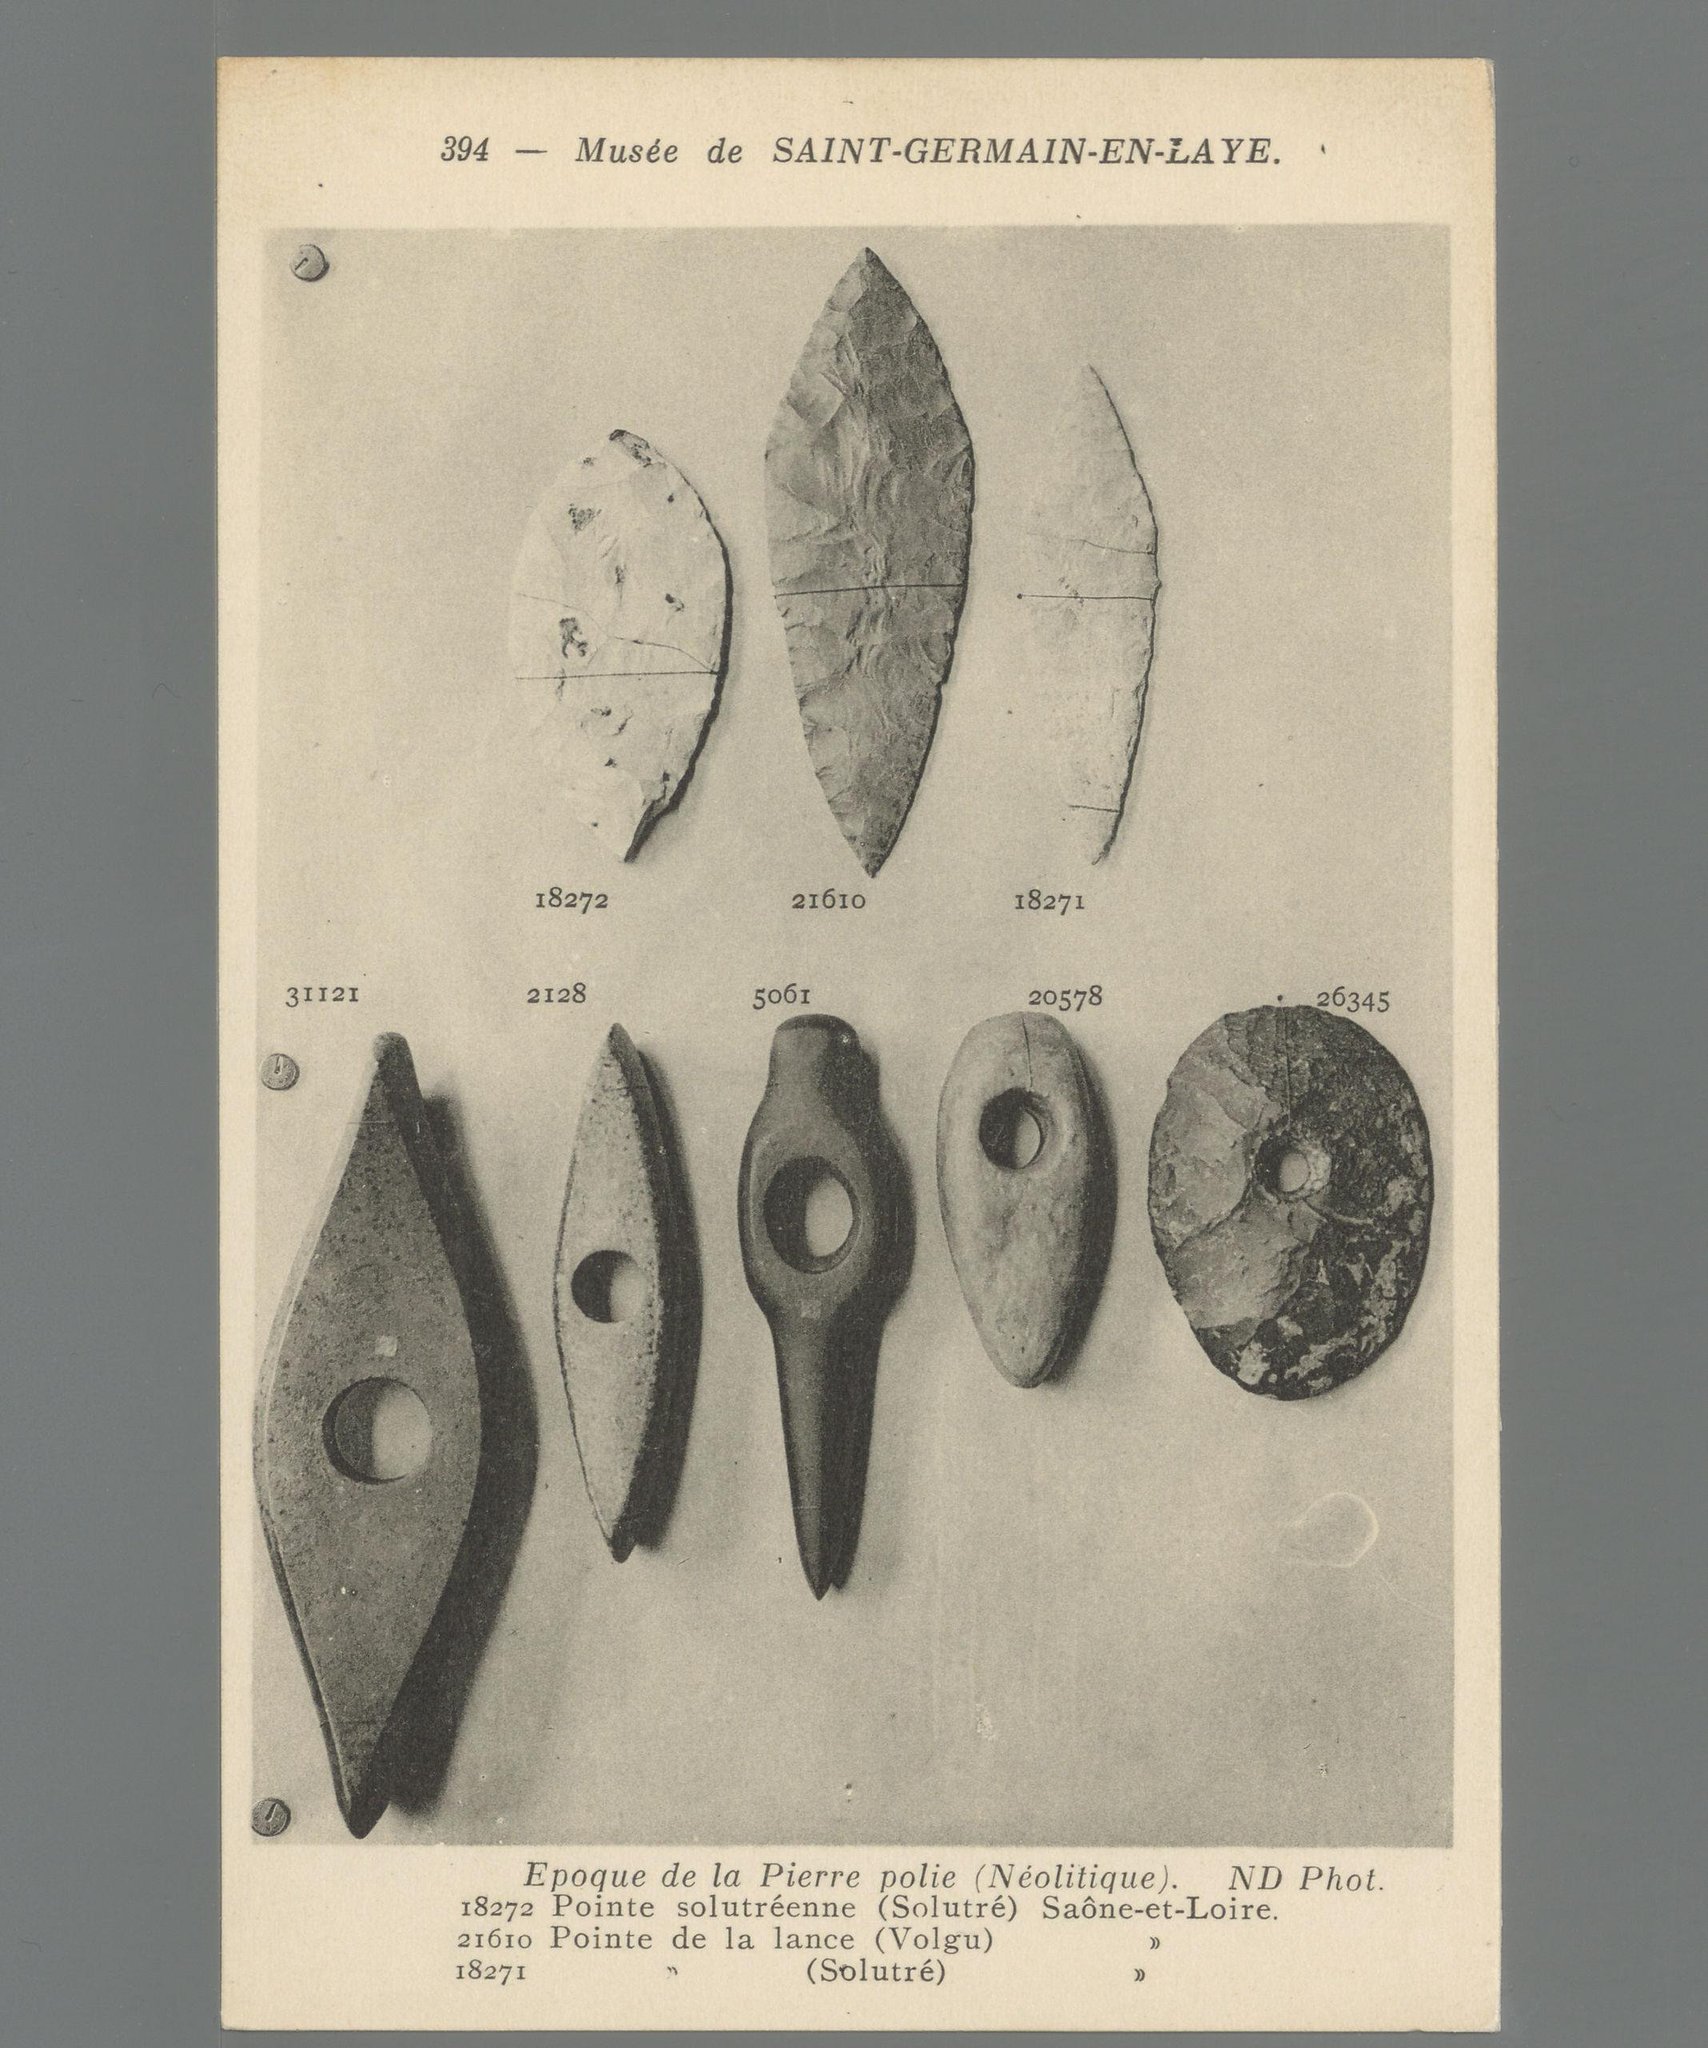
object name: photomechanical print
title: Musée de Saint-Germain-en-Laye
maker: Anonymous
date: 1903-1918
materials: cardboard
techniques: photograph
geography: paris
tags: tools, aids, implements ~ crafts and industries, permanent exhibition, museum